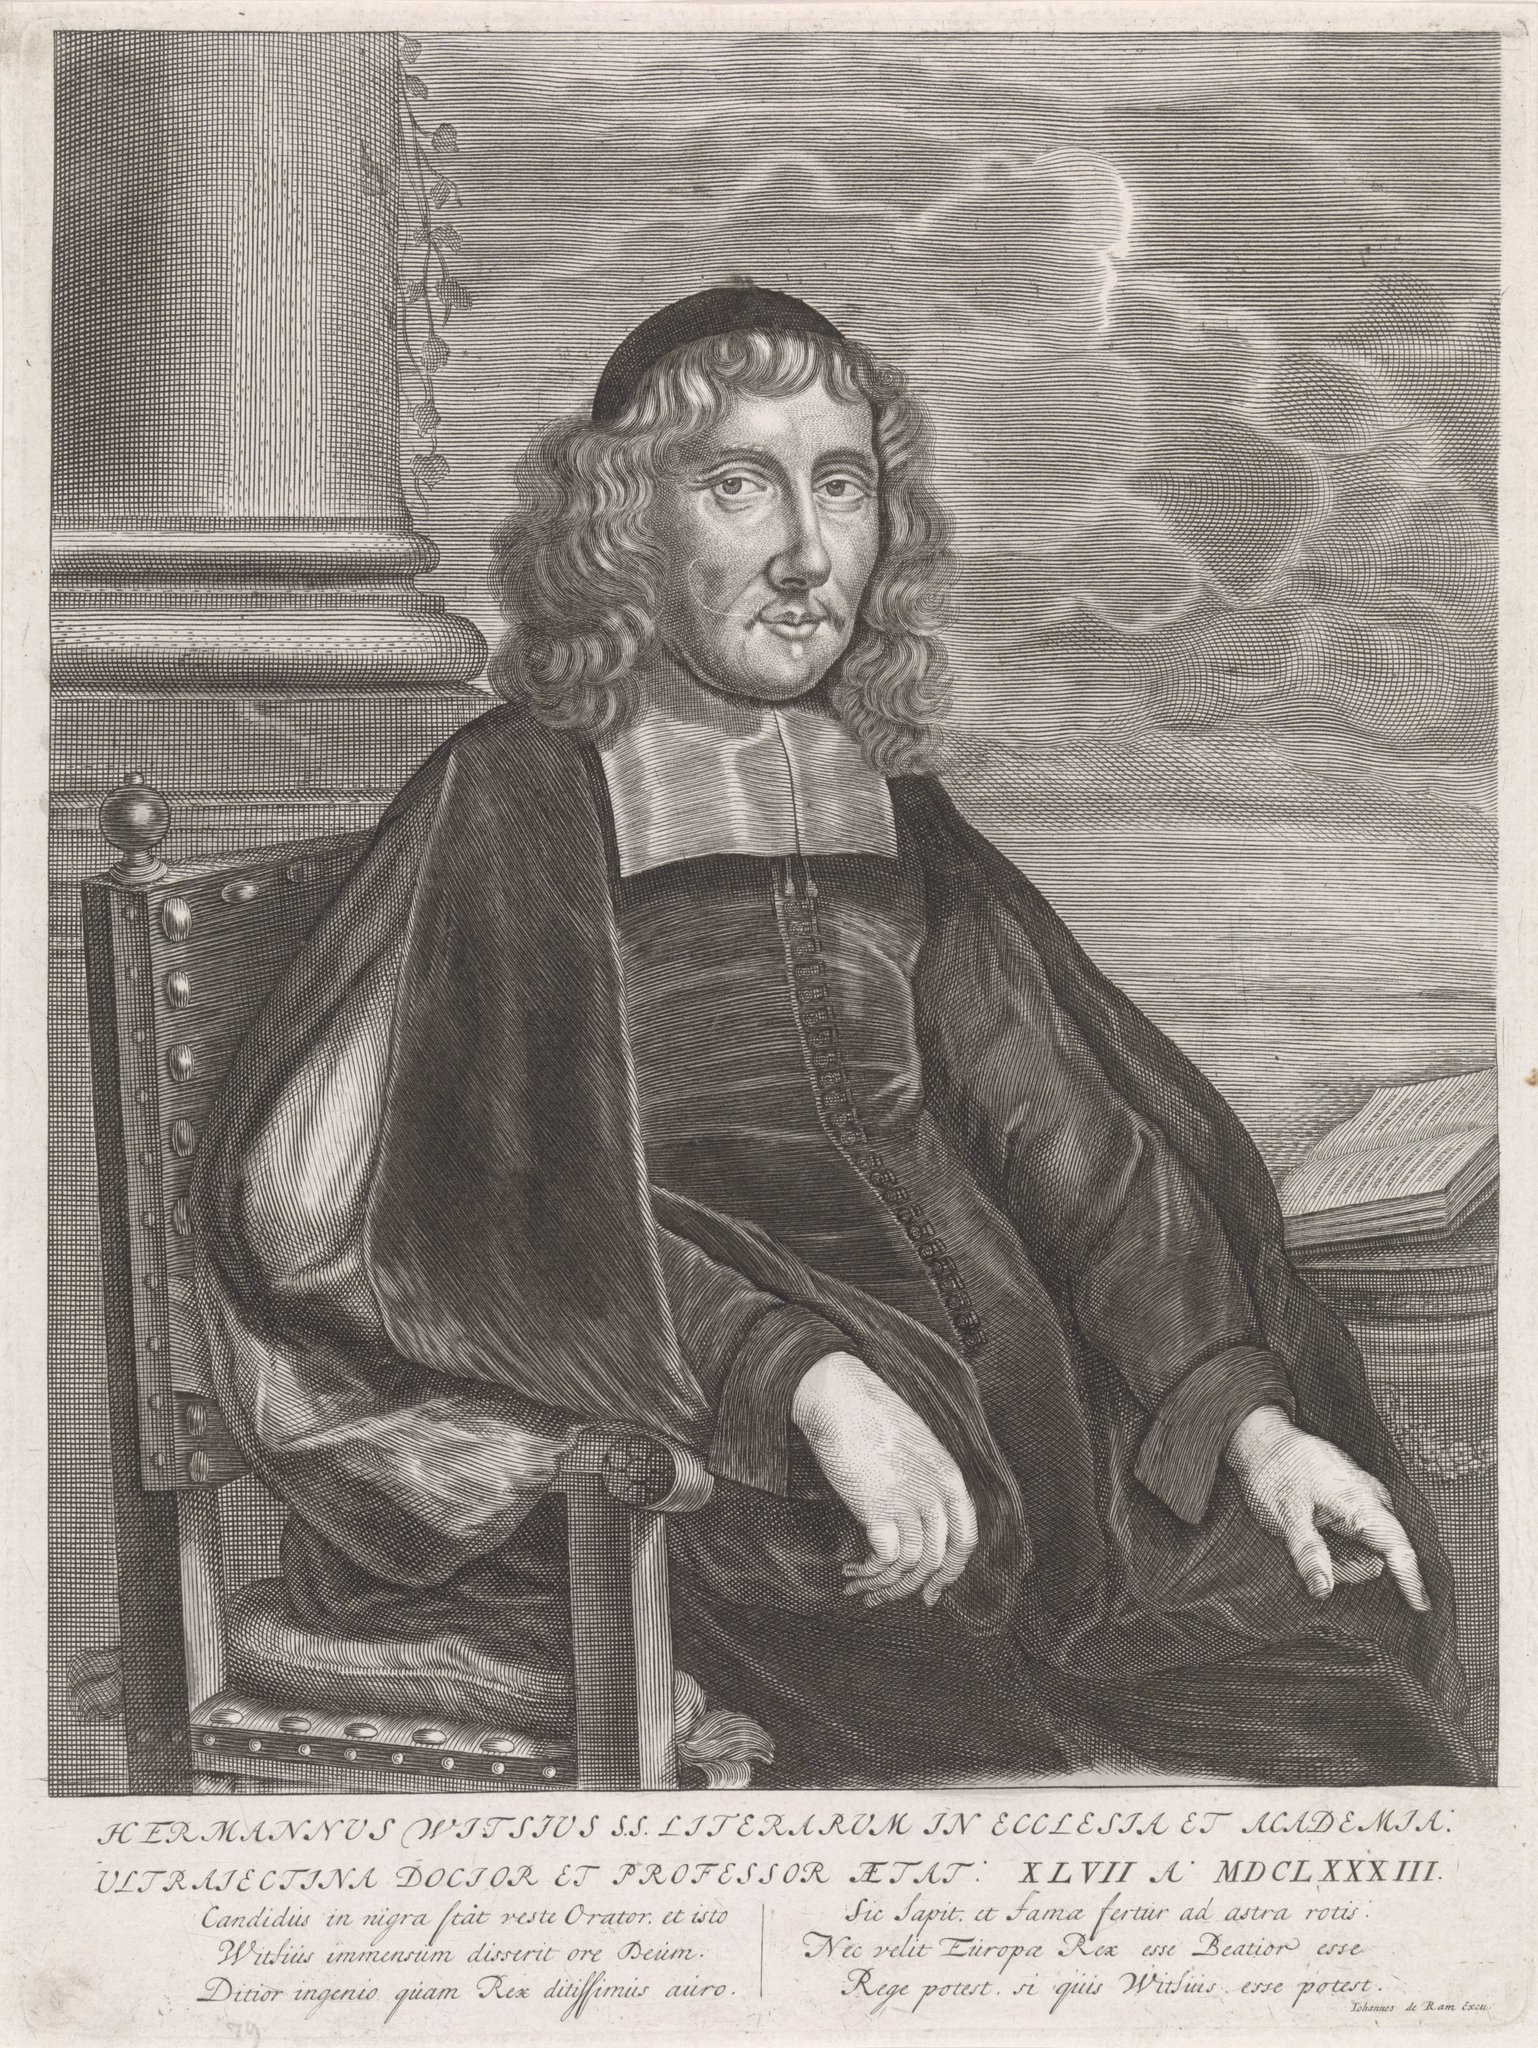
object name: print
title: Portret van de predikant Herman Witsius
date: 1683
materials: paper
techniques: engraving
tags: enkhuizen, leiden, herman witsius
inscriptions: collector's mark: Lugt 2228